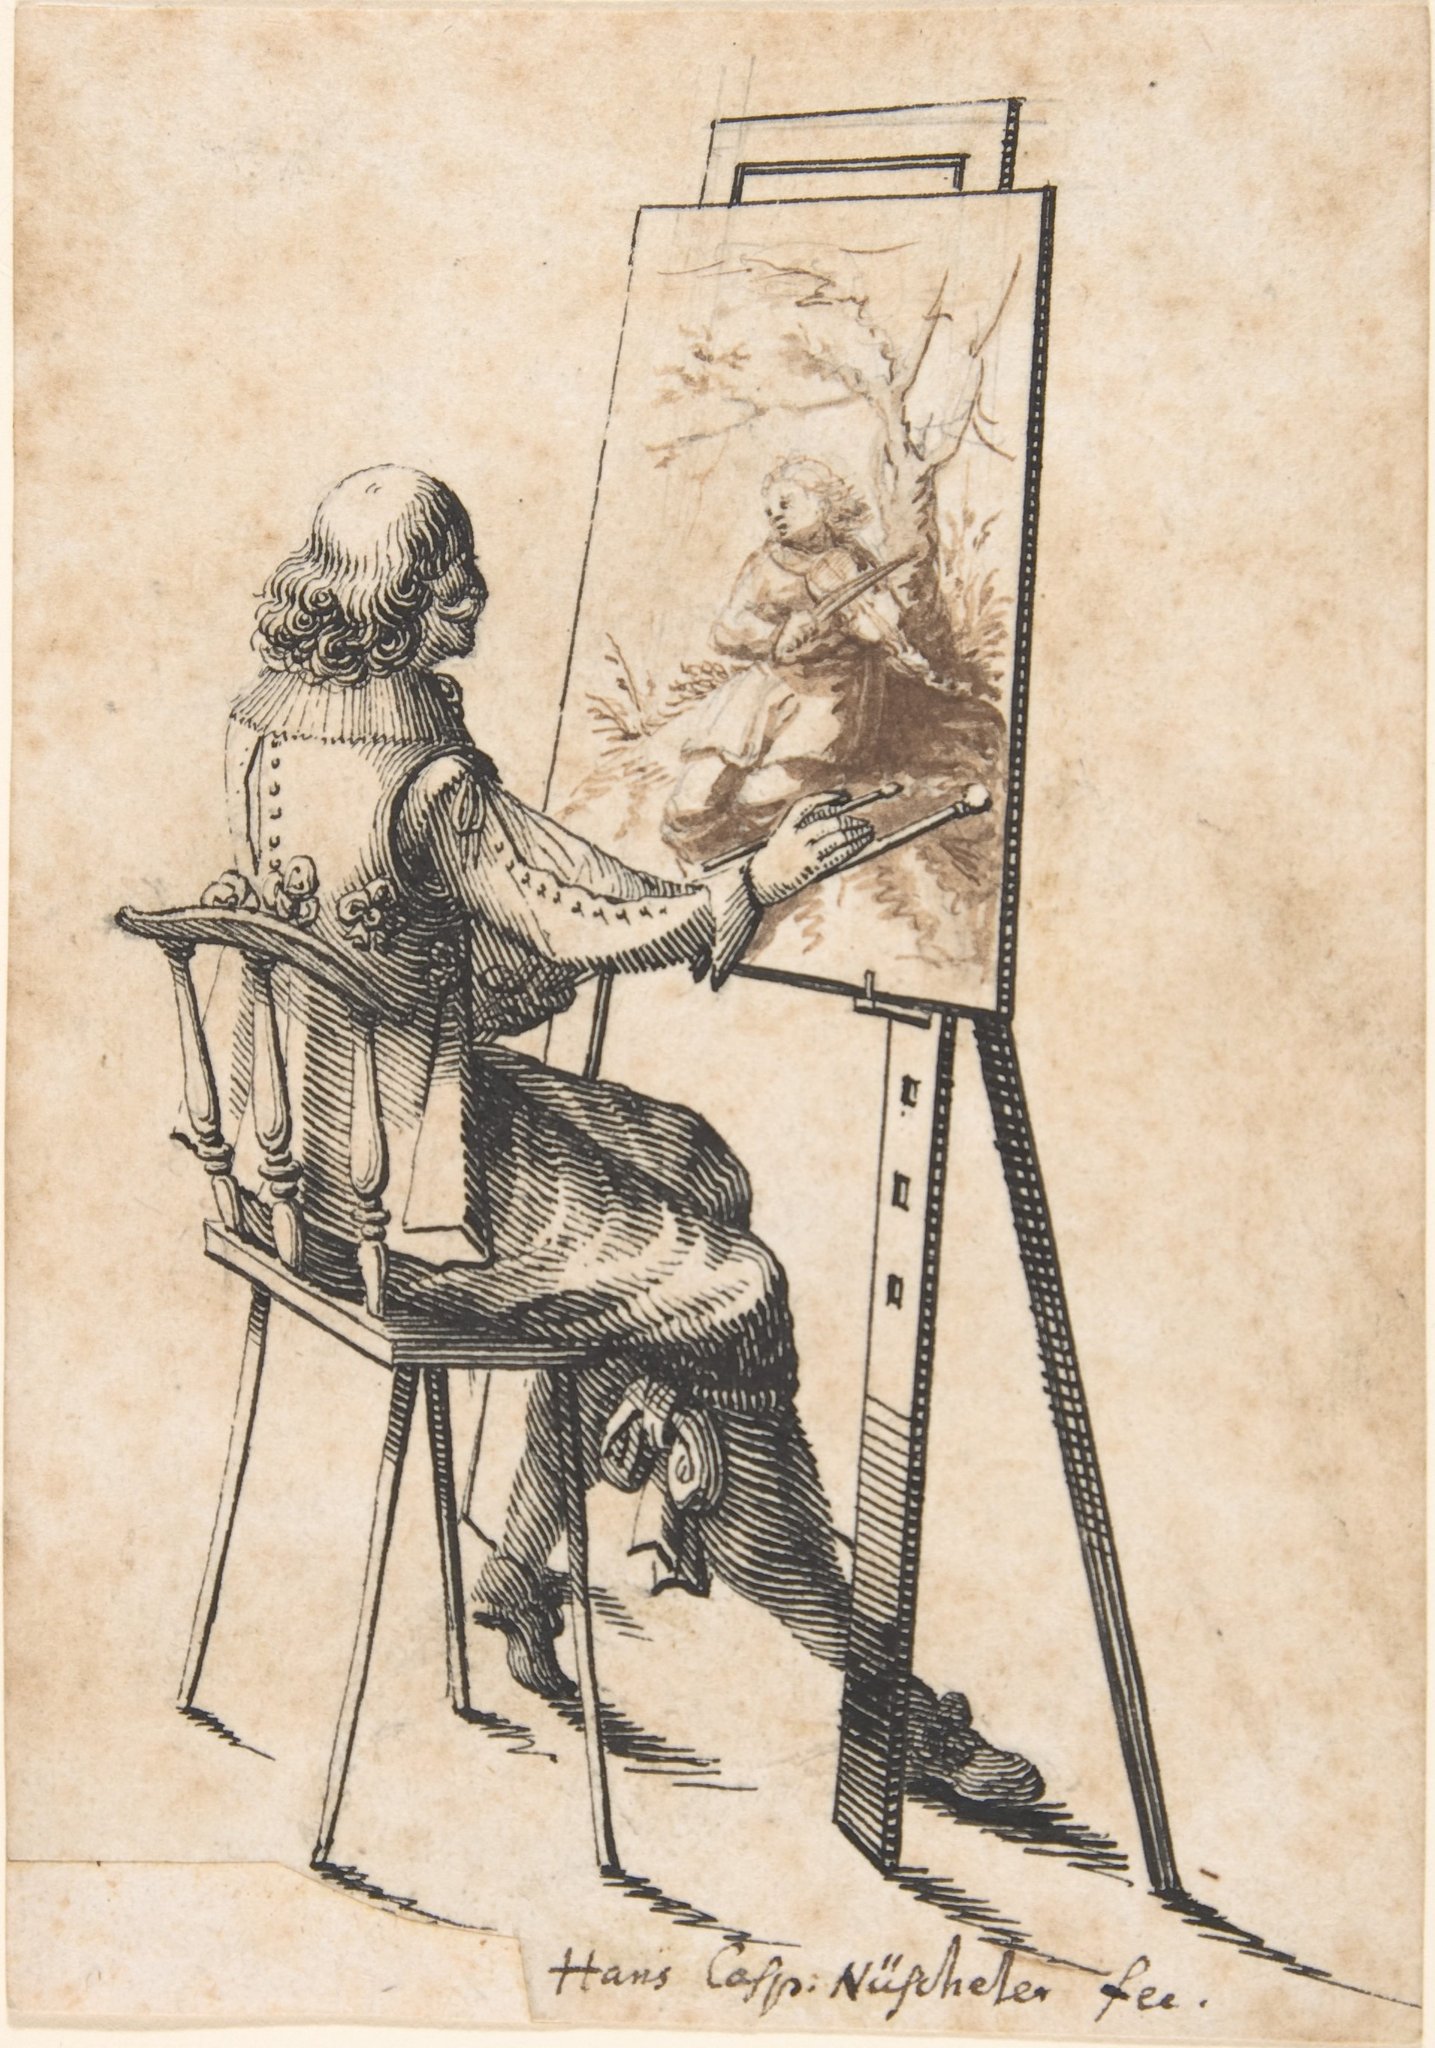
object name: drawing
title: A Painter at his Easel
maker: hans caspar nüscheler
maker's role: artist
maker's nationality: swiss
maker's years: 1615-1652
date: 1615-1652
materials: graphite, ink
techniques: brush, pen, wash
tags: painting,men,artists,easels